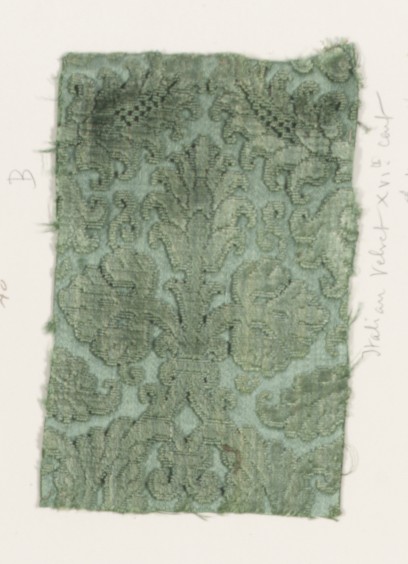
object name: fragment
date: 1601-1700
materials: silk